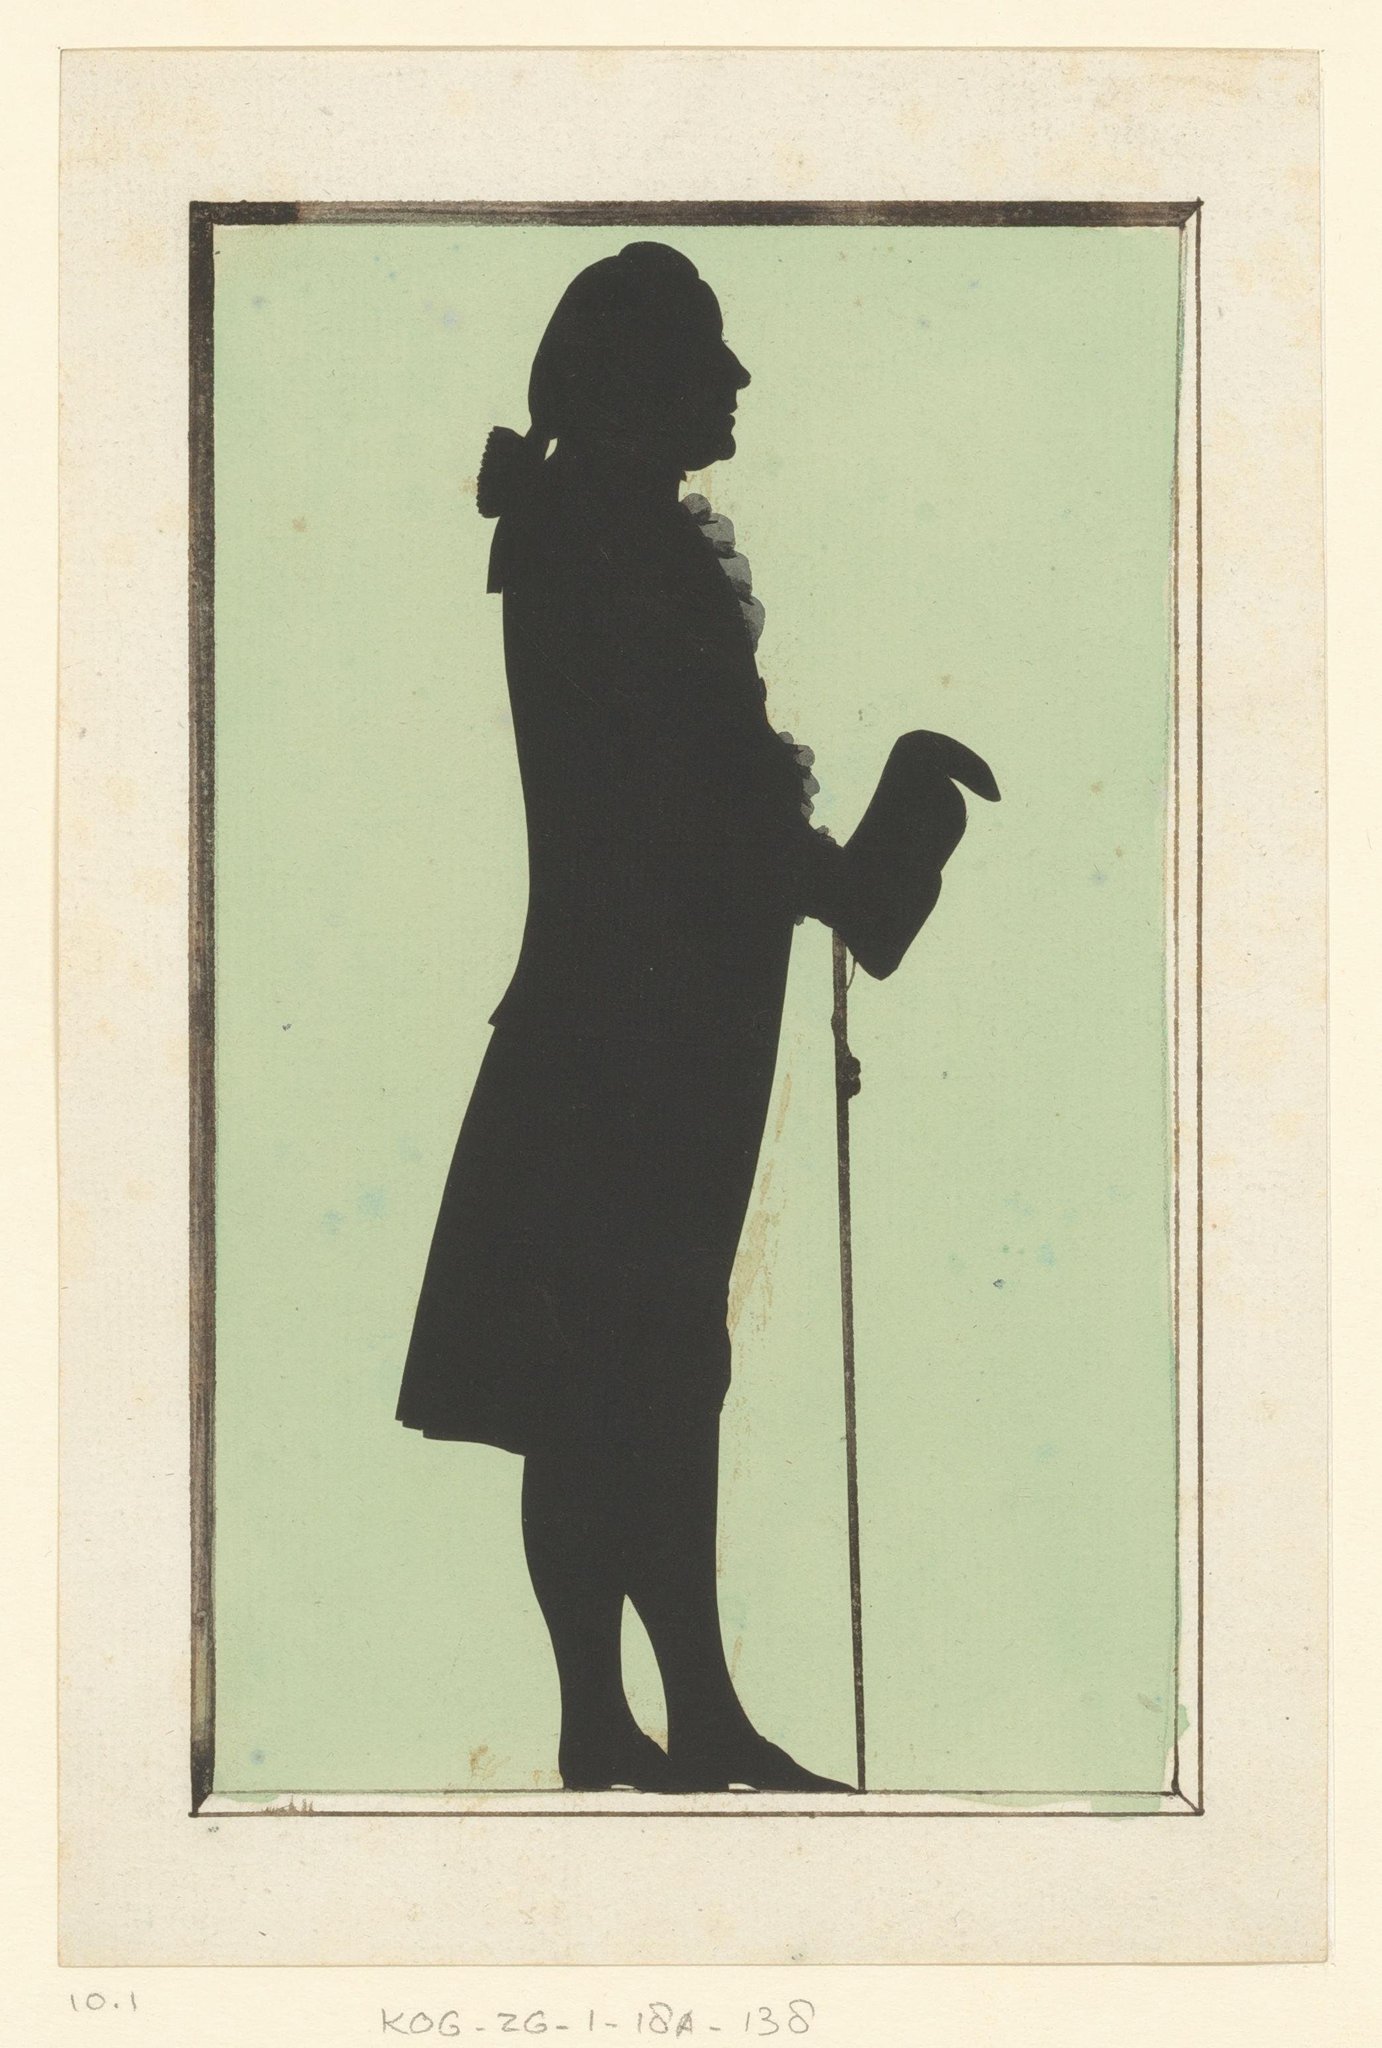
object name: silhouette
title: Silhouetportret van een onbekende staande man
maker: joseph adolf schmetterling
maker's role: draughtsman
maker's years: 1751-1828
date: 1785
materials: paint, paper, pencil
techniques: brush, snipping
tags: standing figure, walking-stick, staff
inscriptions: collector's mark: Lugt 1641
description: Een staande heer met pruik met staart en strik, gekleed in een knielange jas. Hij leunt op een wandelstok. In zijn hand een steek. De afbeelding is omkaderd met een dubbele lijn. Onderwerpsrubrieken binnen de Atlas Zeden en Gewoonten: Schoone kunsten, Silhouetportretten.